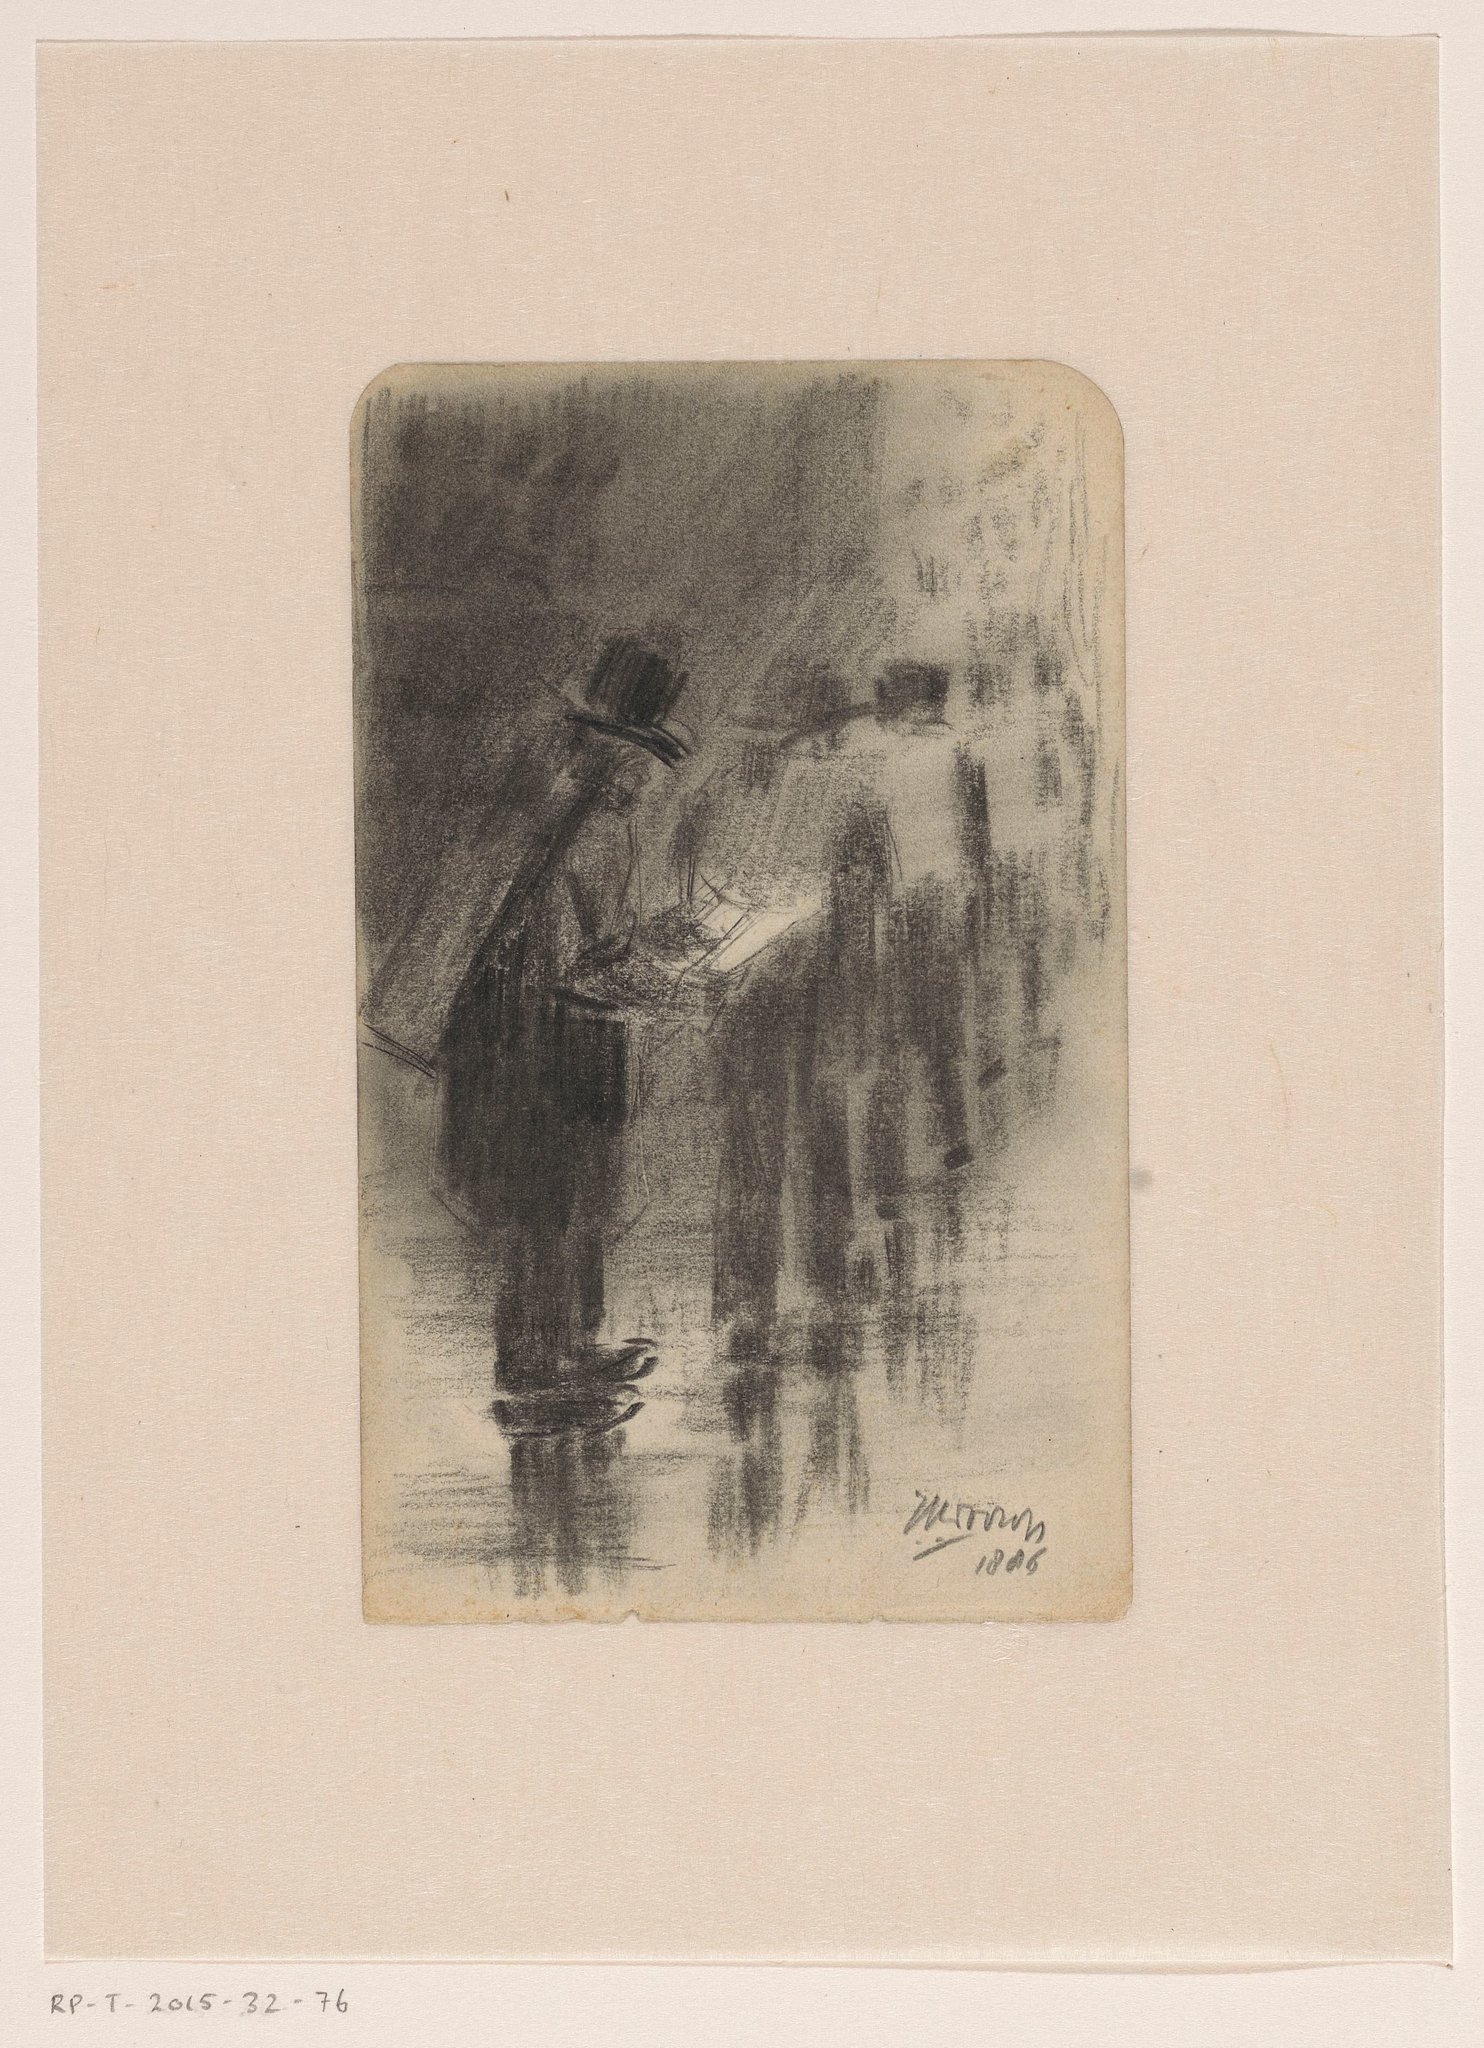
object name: drawing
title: Lezende man aan het einde van een rij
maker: jan toorop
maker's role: draughtsman, painter, print maker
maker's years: 1858-1928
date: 1886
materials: chalk, paper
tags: reading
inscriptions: collector's mark: Lugt 4780